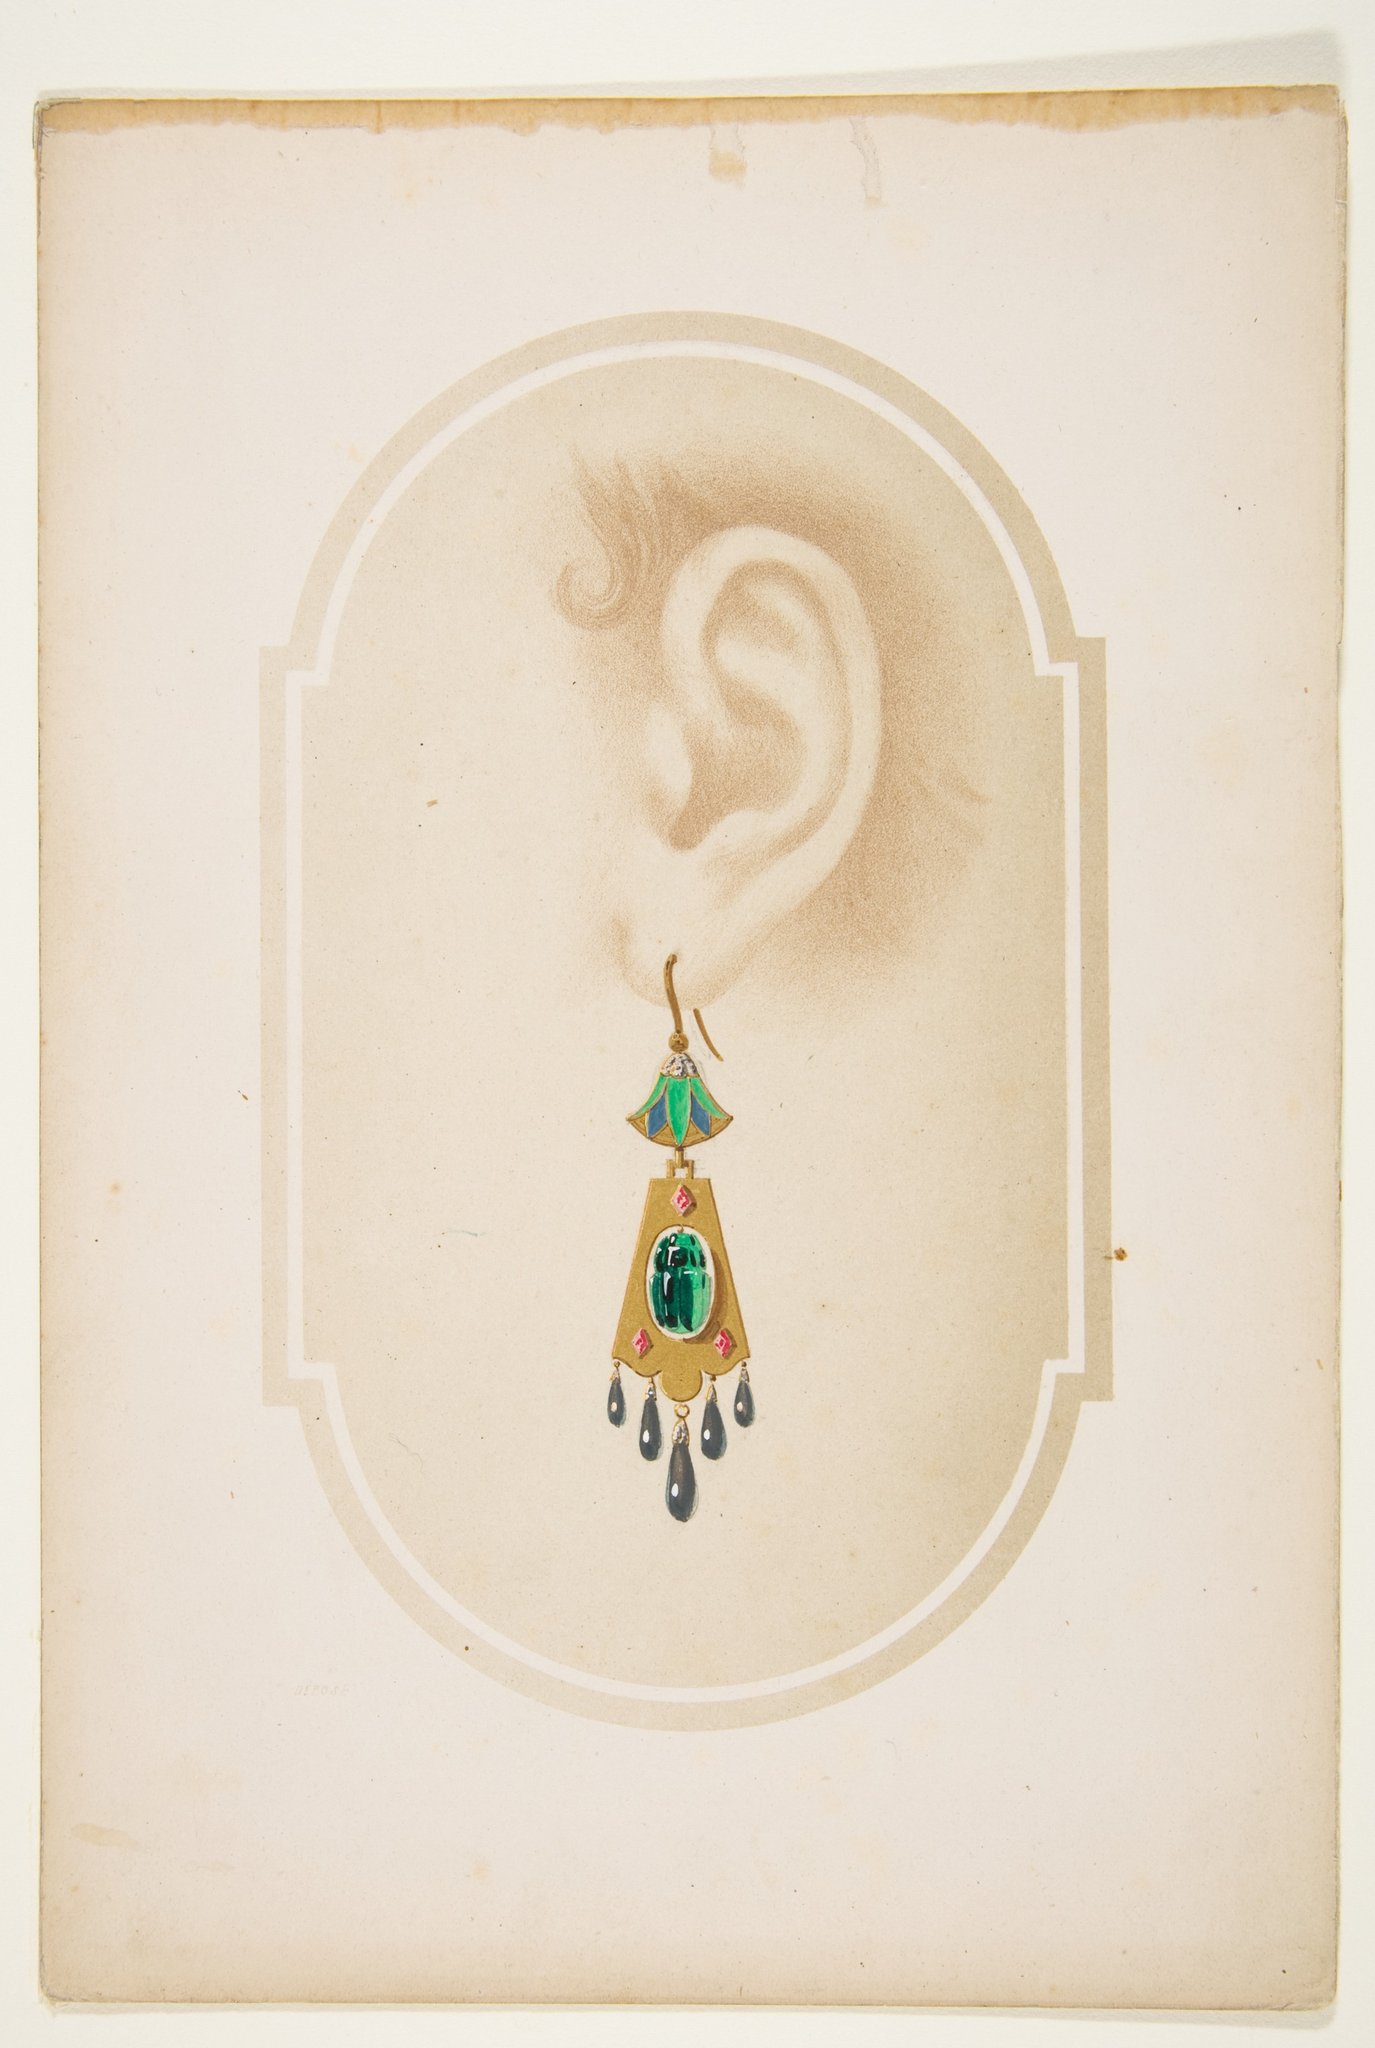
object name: drawing ornament architecture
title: Design for an earring with a green scarab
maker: anonymous, french, 19th century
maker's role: artist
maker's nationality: french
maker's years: 1800-1900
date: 1801-1900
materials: cardboard, ink, watercolor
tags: earrings,scarabs